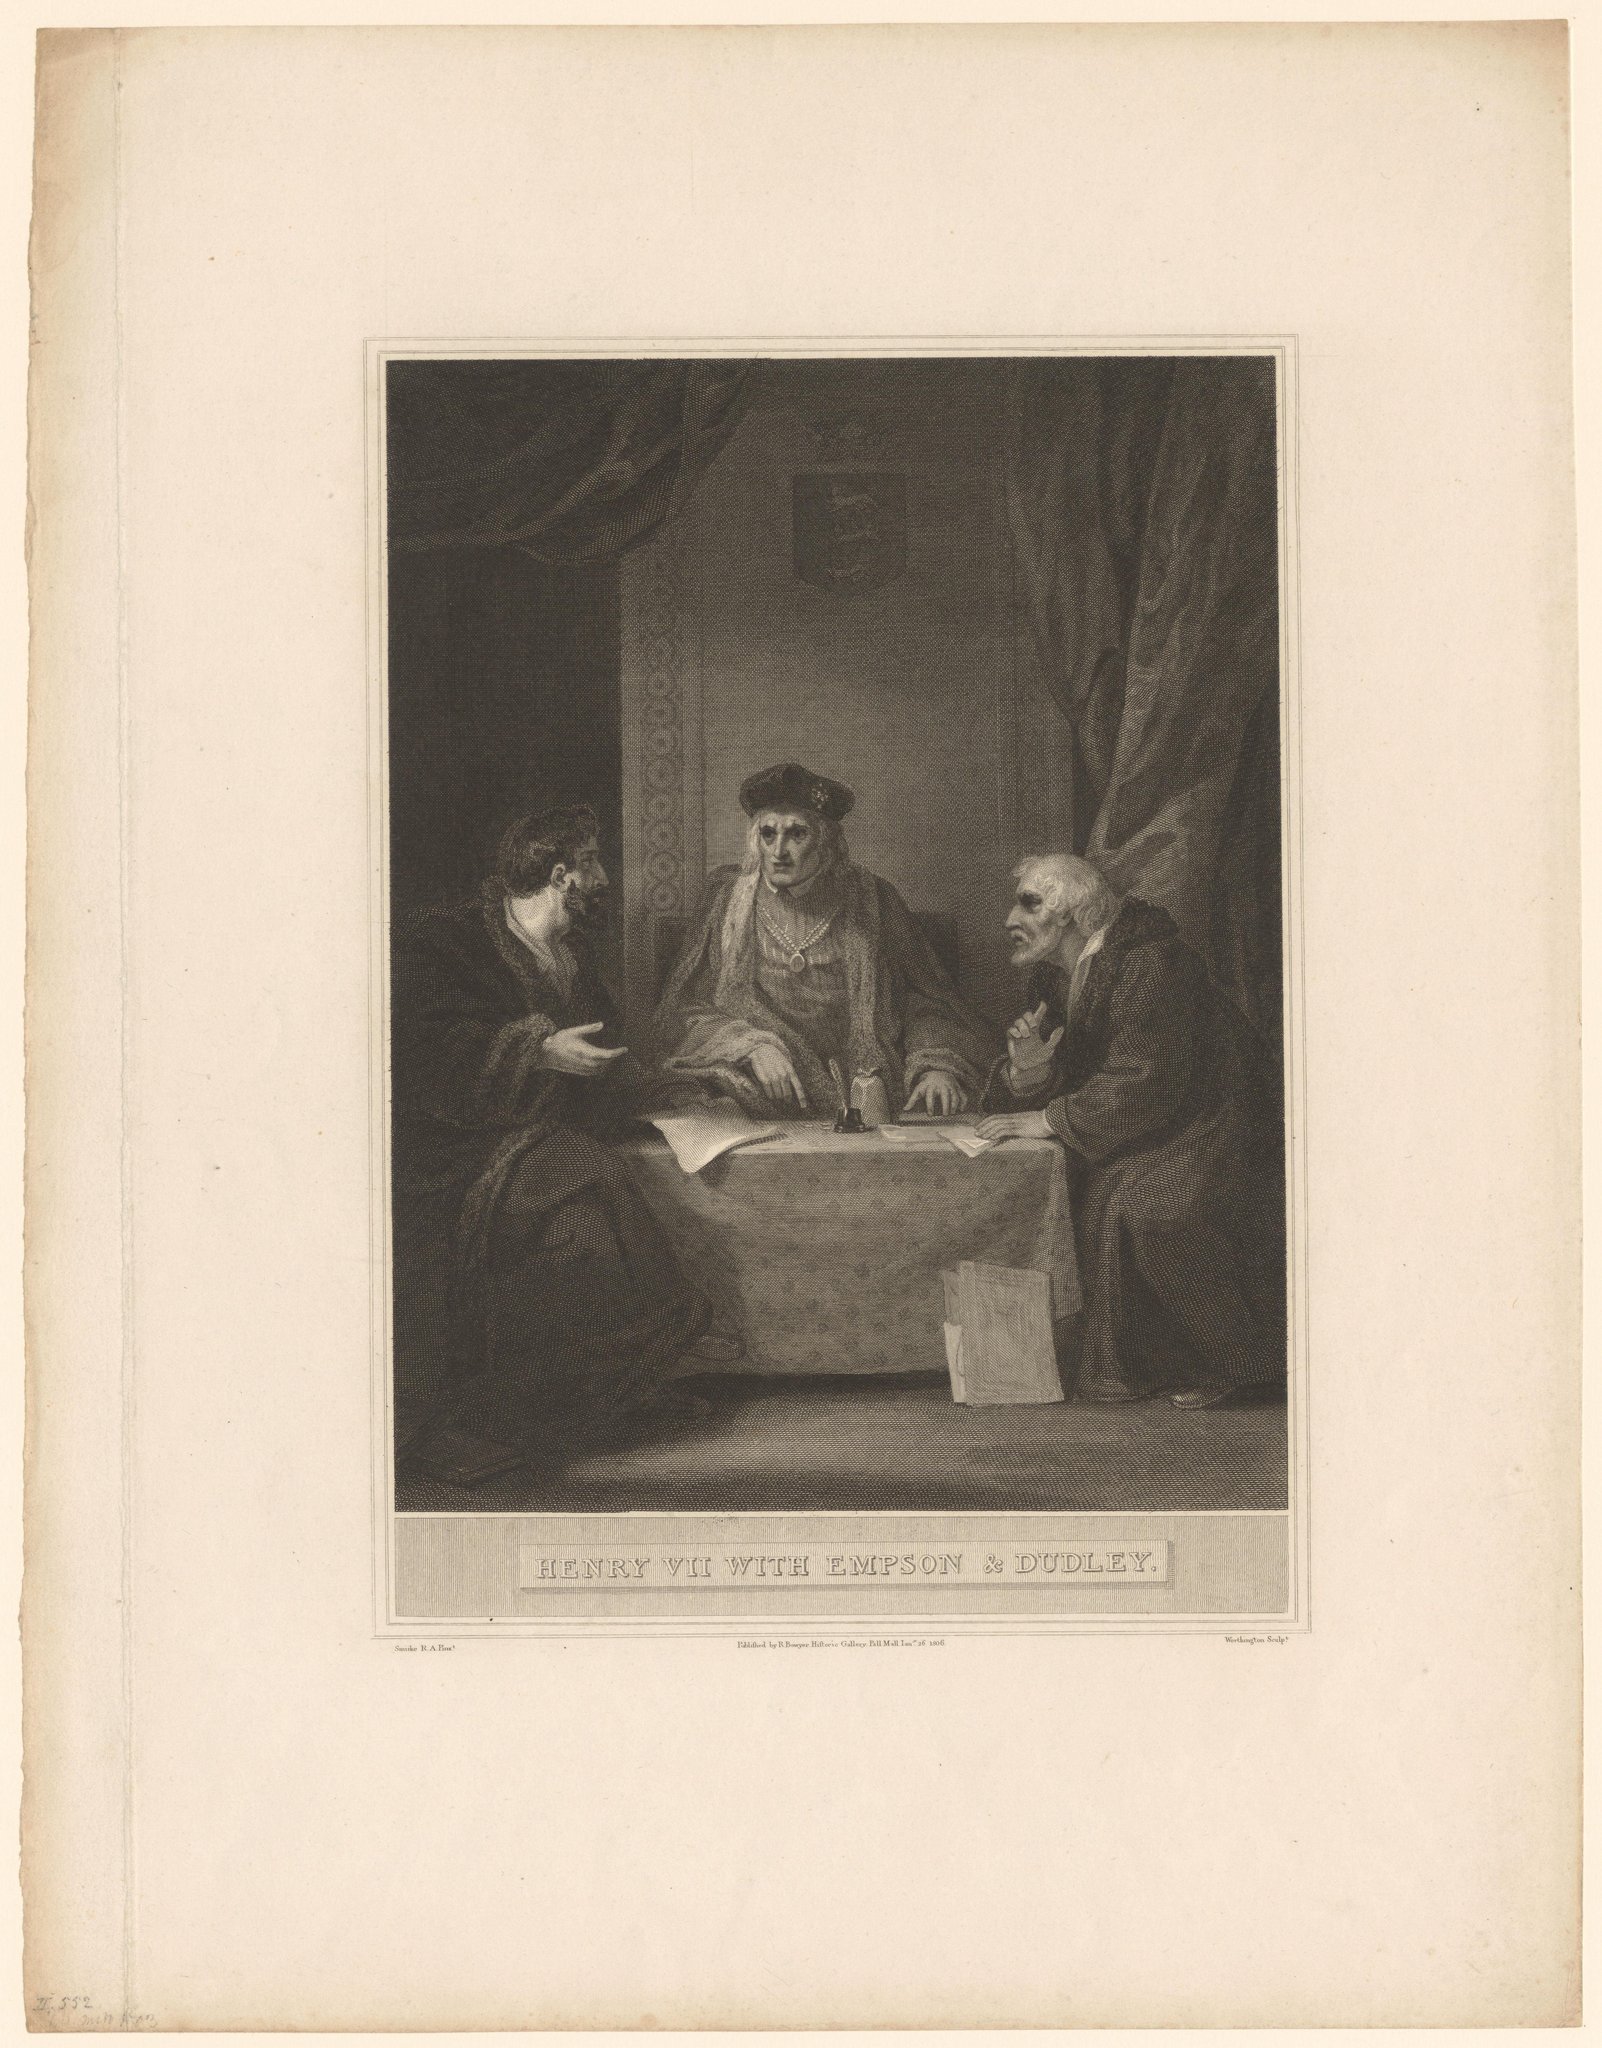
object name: book illustration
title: Koning Hendrik VII aan tafel met Edmund Dudley en Richard Empson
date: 1806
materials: paper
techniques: etching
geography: london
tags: politician, historical persons, politician, e.g. party leader, conversation, dialogue; conversation piece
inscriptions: collector's mark: Lugt 2228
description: Deze prent is gebruikt in: The History of England. Londen: Robert Bowyer, 1806. Deze editie is gebaseerd op David Hume's uitgave van 'The History of England', waarvan het eerste deel verscheen in 1754 en het laatste in 1762.